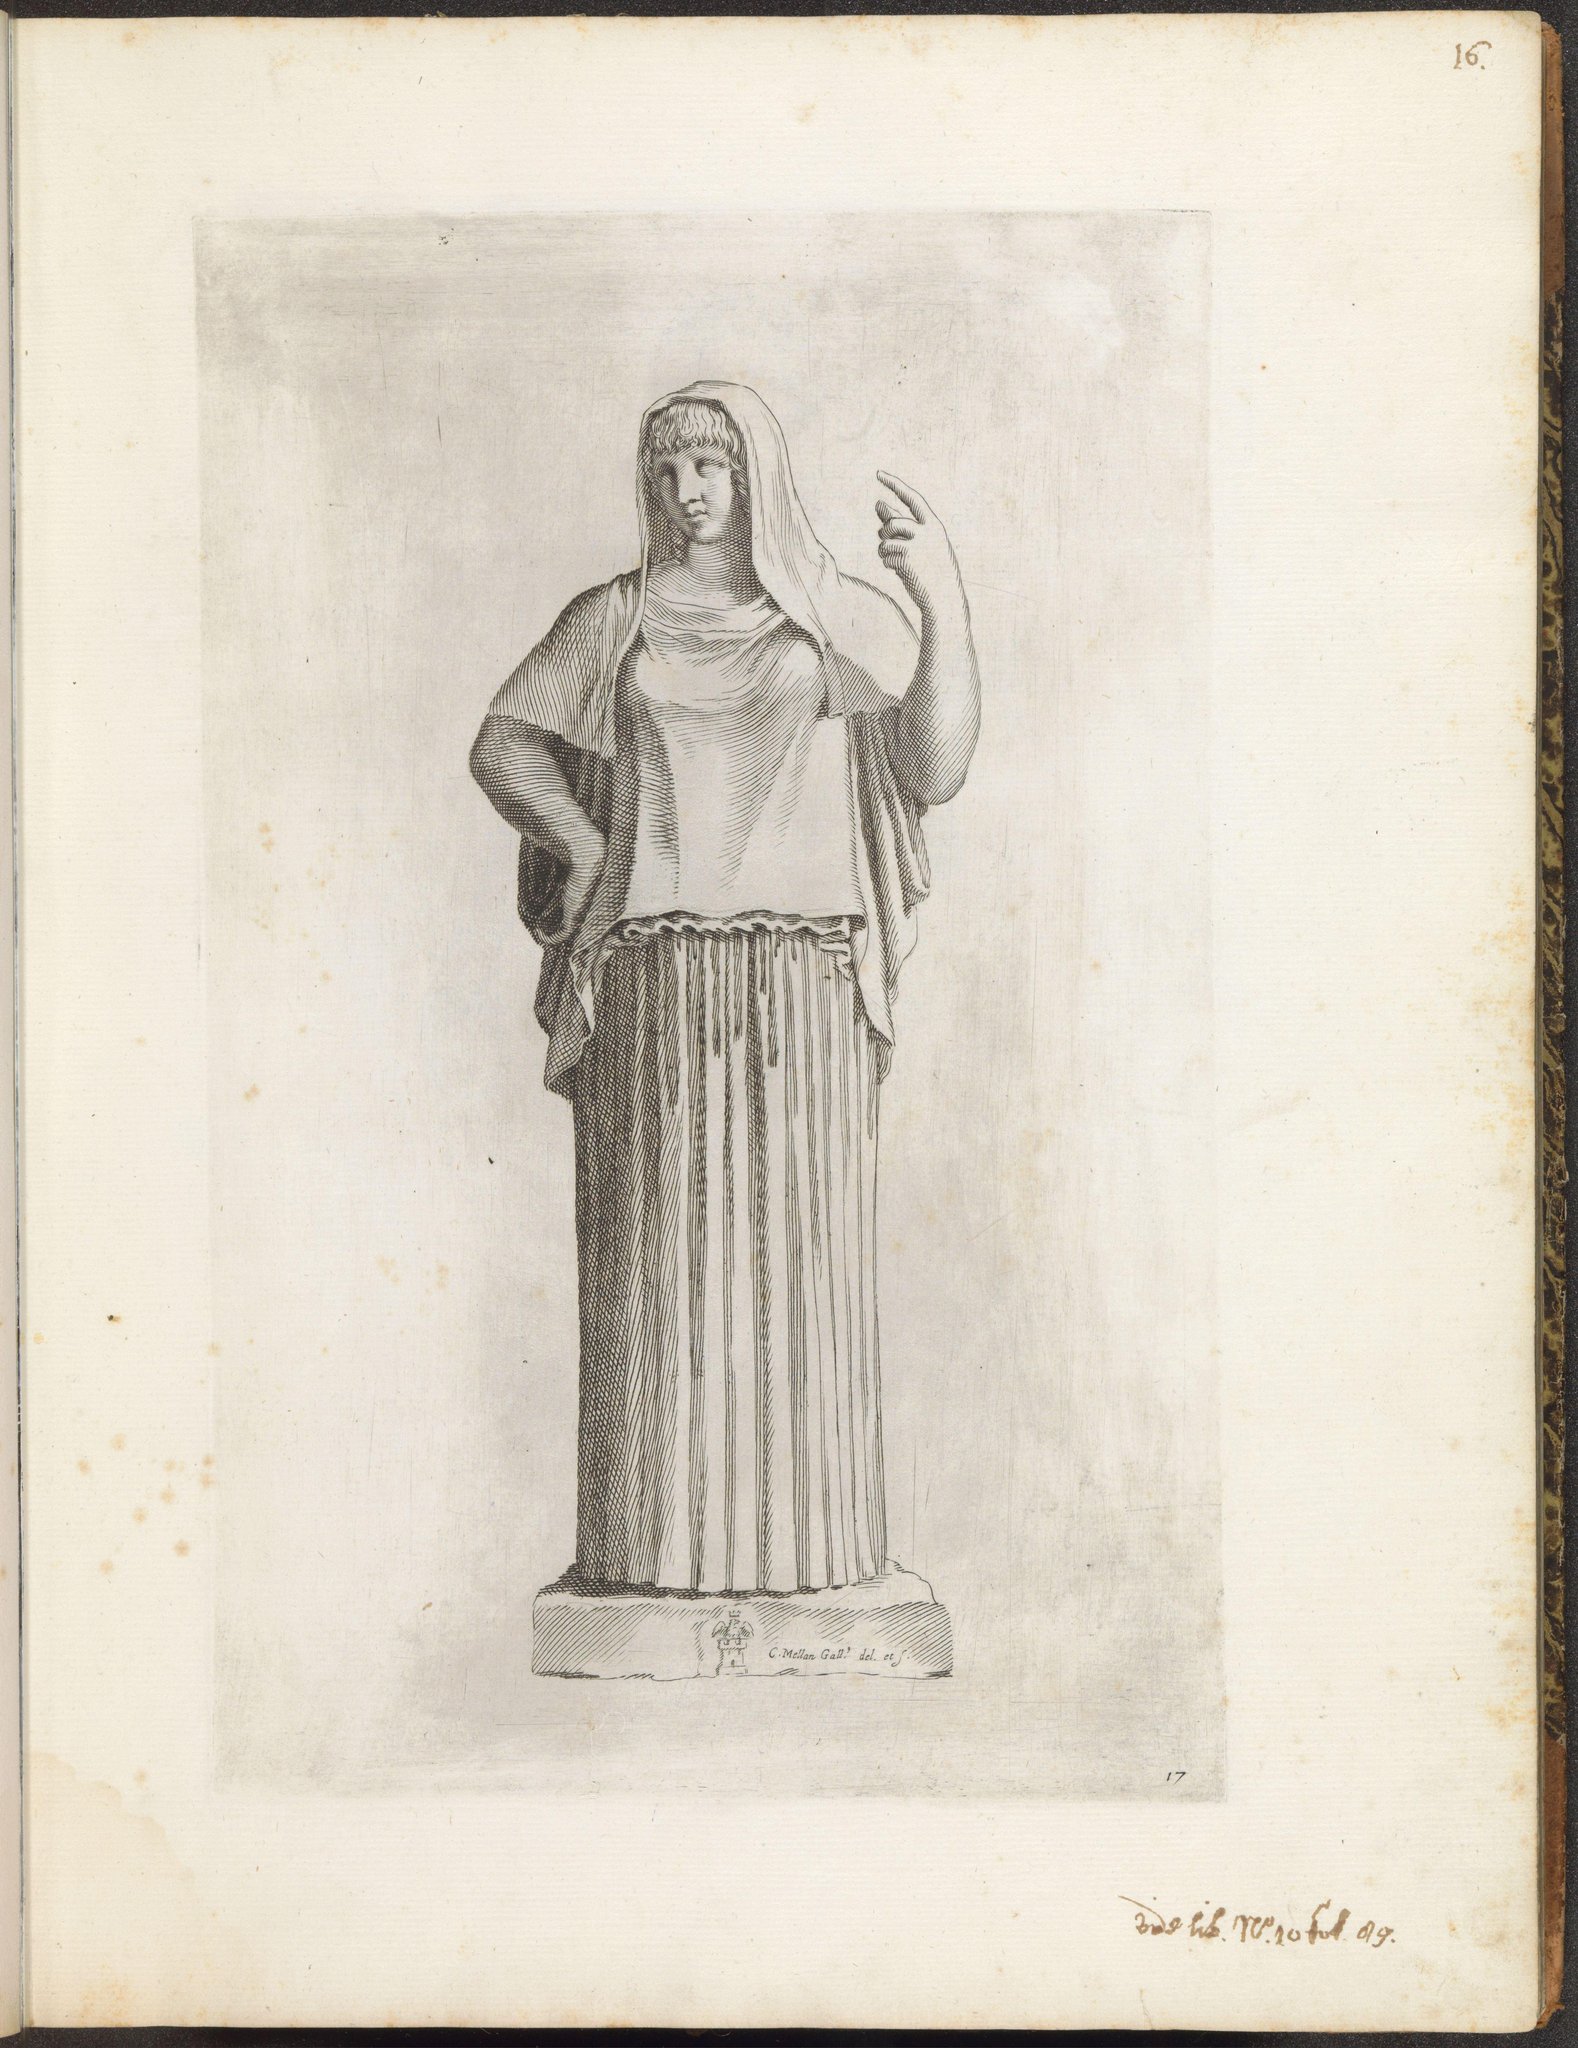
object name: print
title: Galleria Giustiniana del Marchese Vincenzo Giustiniani I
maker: claude mellan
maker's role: draughtsman, print maker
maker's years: 1598-1688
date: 1636-1647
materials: paper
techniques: engraving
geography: rome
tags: (story of) vesta (hestia), piece of sculpture, reproduction of a piece of sculpture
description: Standbeeld van de Griekse godin Hestia met haar rechterhand in haar zij en met haar linkerhand omhoog wijzend. Op de basis het wapenschild van Vincenzo Giustiniani. Prent maakt deel uit van een album met een serie prenten naar de sculpturen in de verzameling in de Galleria Giustiniani te Rome.